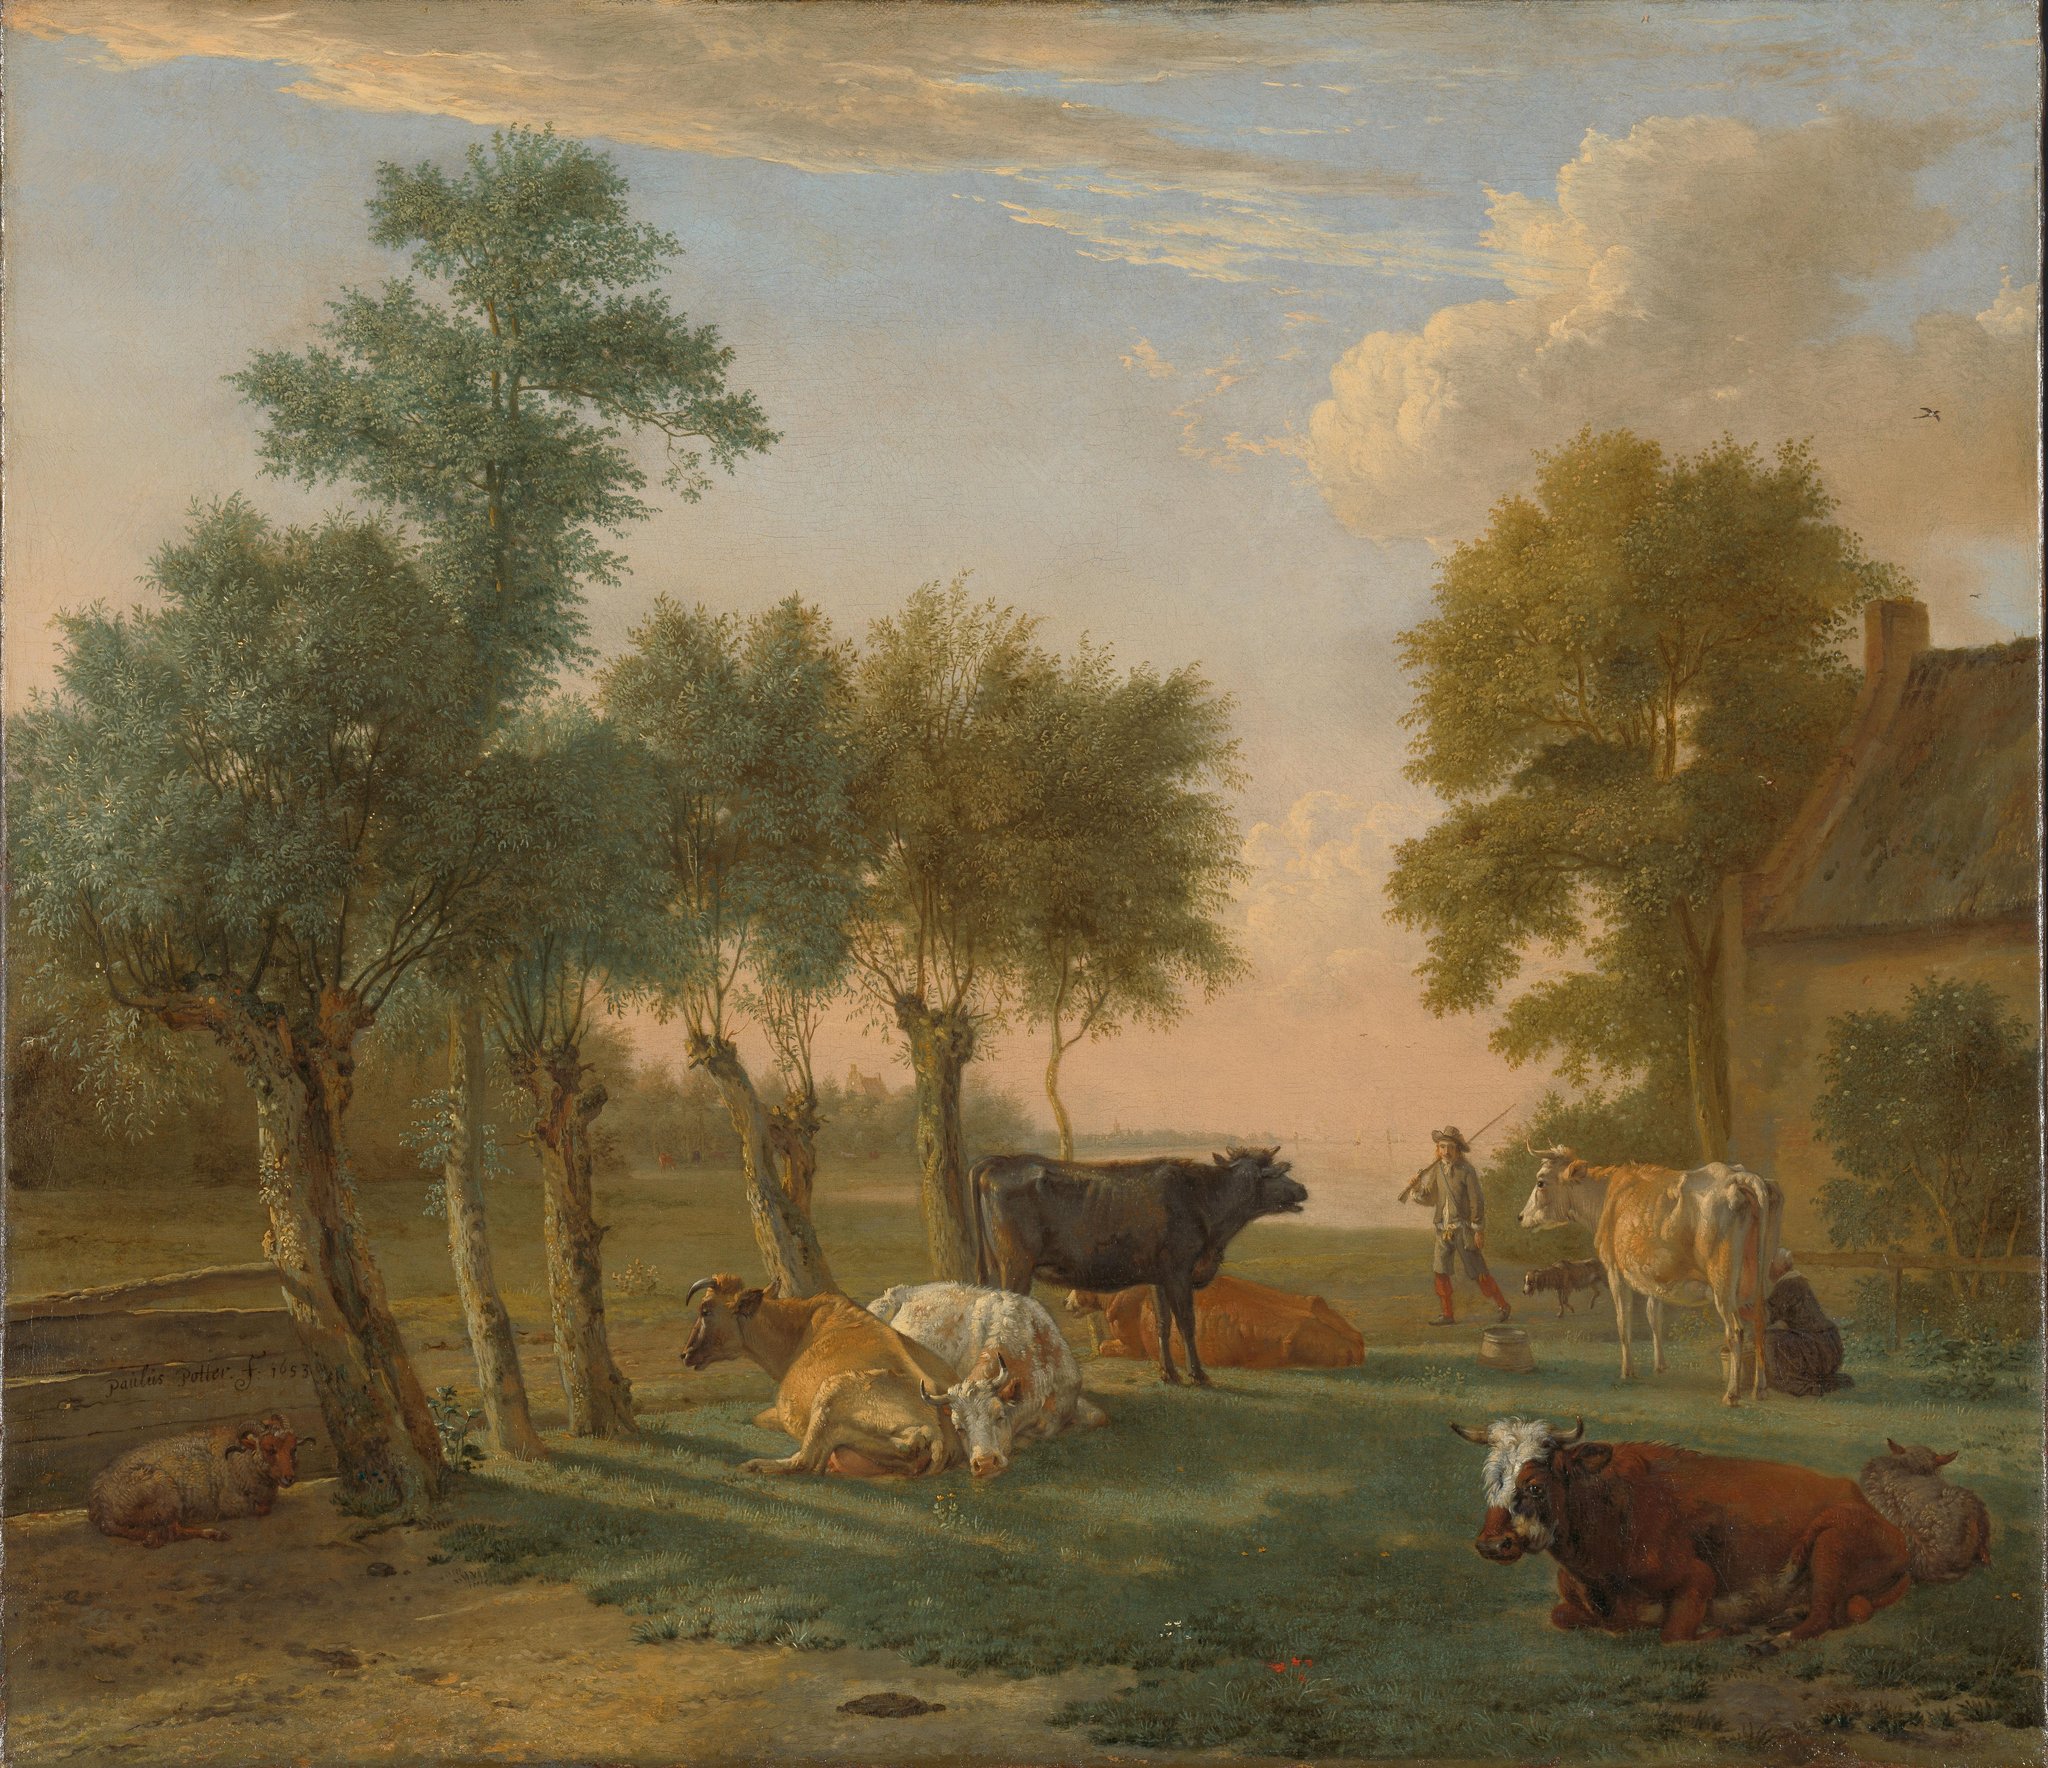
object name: painting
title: Cows in a Meadow near a Farm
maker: paulus potter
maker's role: draughtsman, painter, print maker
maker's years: 1625-1654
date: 1653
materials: canvas, oil, paint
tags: cow, meadow, pasture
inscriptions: signature and date: ‘Paulus Potter. f: 1653.’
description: Paulus Potter favoured painting animals in the countryside and at farms. He rendered the typical Dutch landscape – the pollard willows, the meadow, and the pond in the background –with great precision. In this painting the sun hangs low, calling to mind the late afternoon, when the languid cows and sheep take their rest.